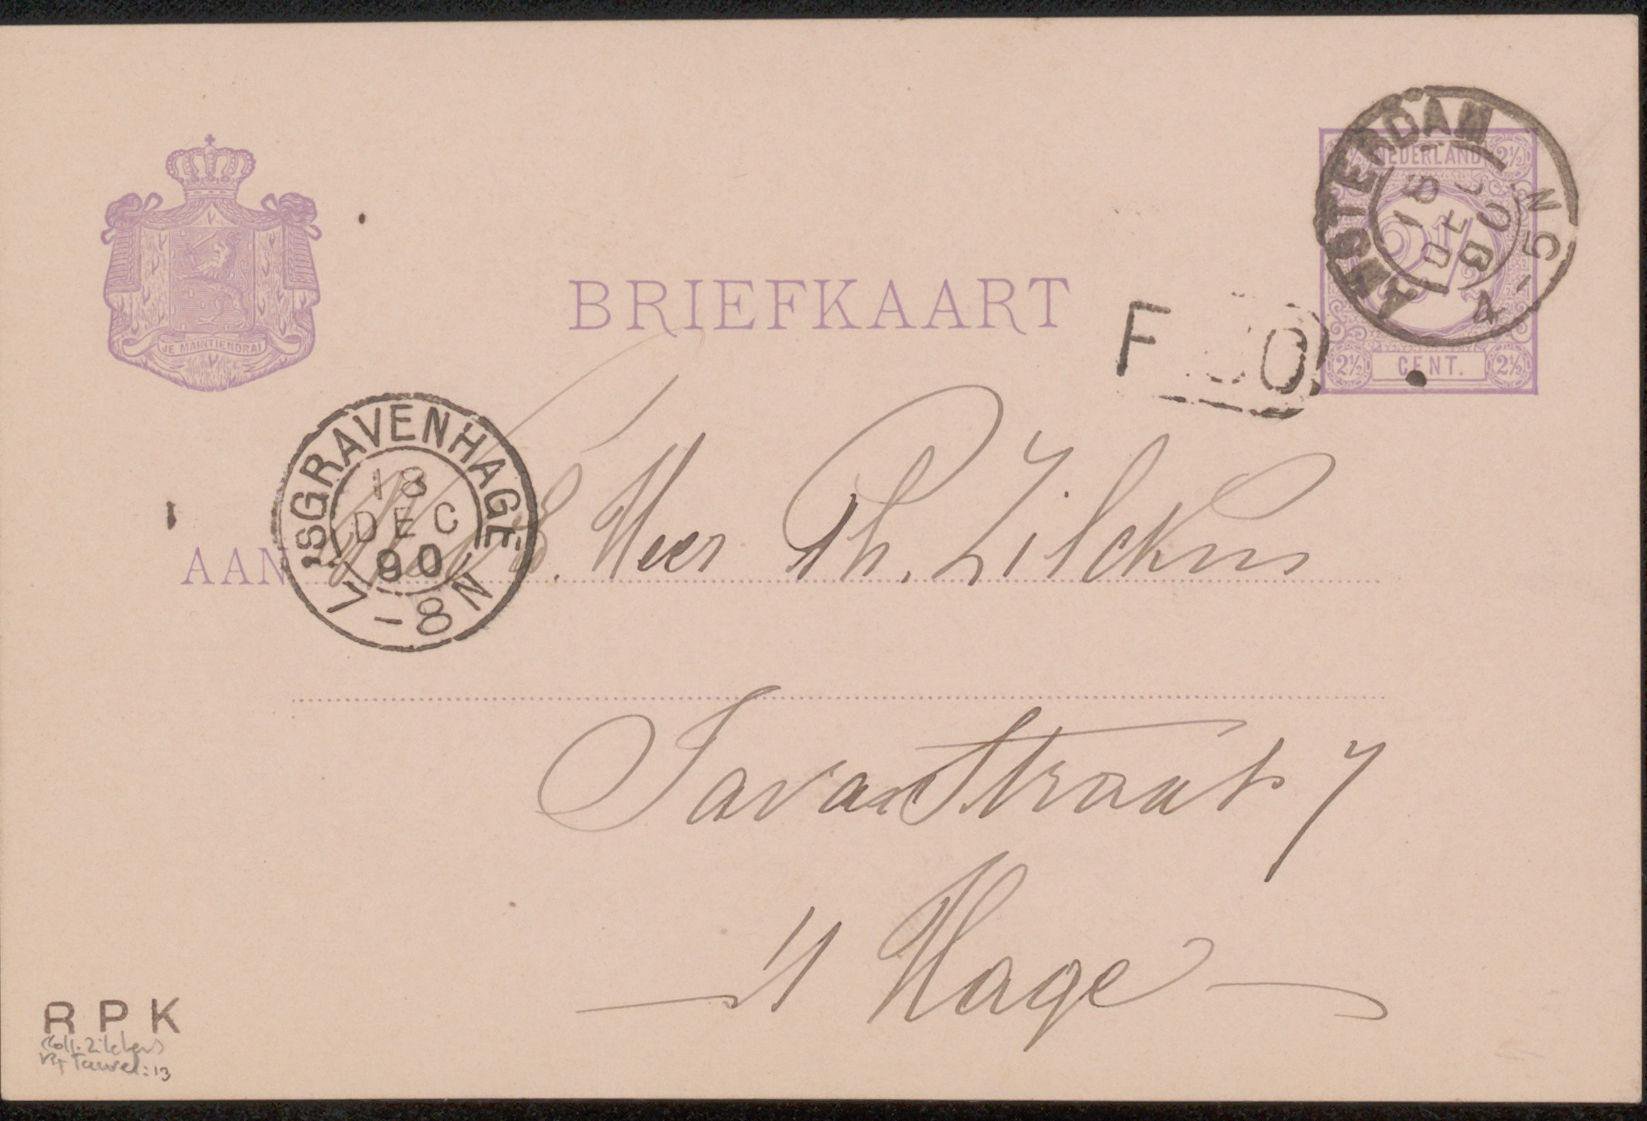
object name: postcard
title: Briefkaart aan Philip Zilcken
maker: edouard taurel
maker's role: draughtsman, print maker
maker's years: 1824-1892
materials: cardboard, ink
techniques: pen, writing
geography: amsterdam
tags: painter, draughtsman, philip zilcken, the hague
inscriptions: collector's mark: ‘RPK’